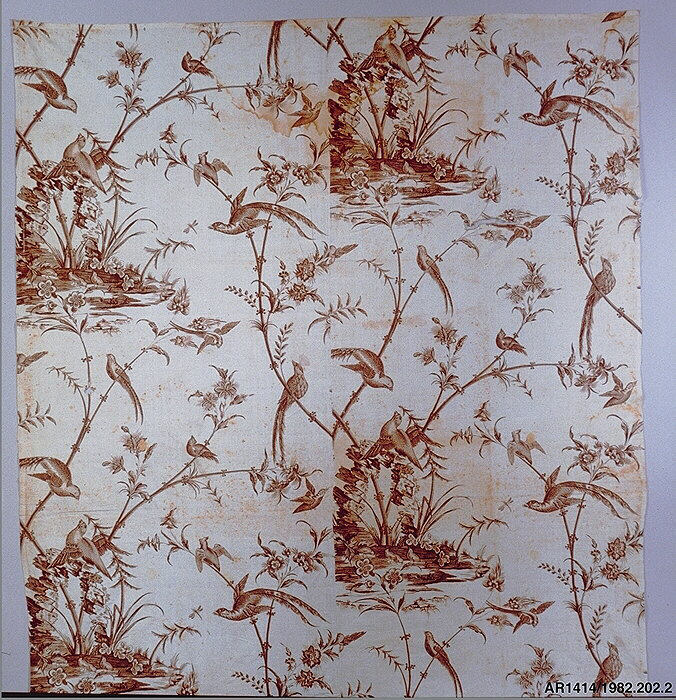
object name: length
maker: bromley hall printworks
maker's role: manufactory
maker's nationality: english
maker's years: 1694-1823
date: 1775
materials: cotton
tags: birds